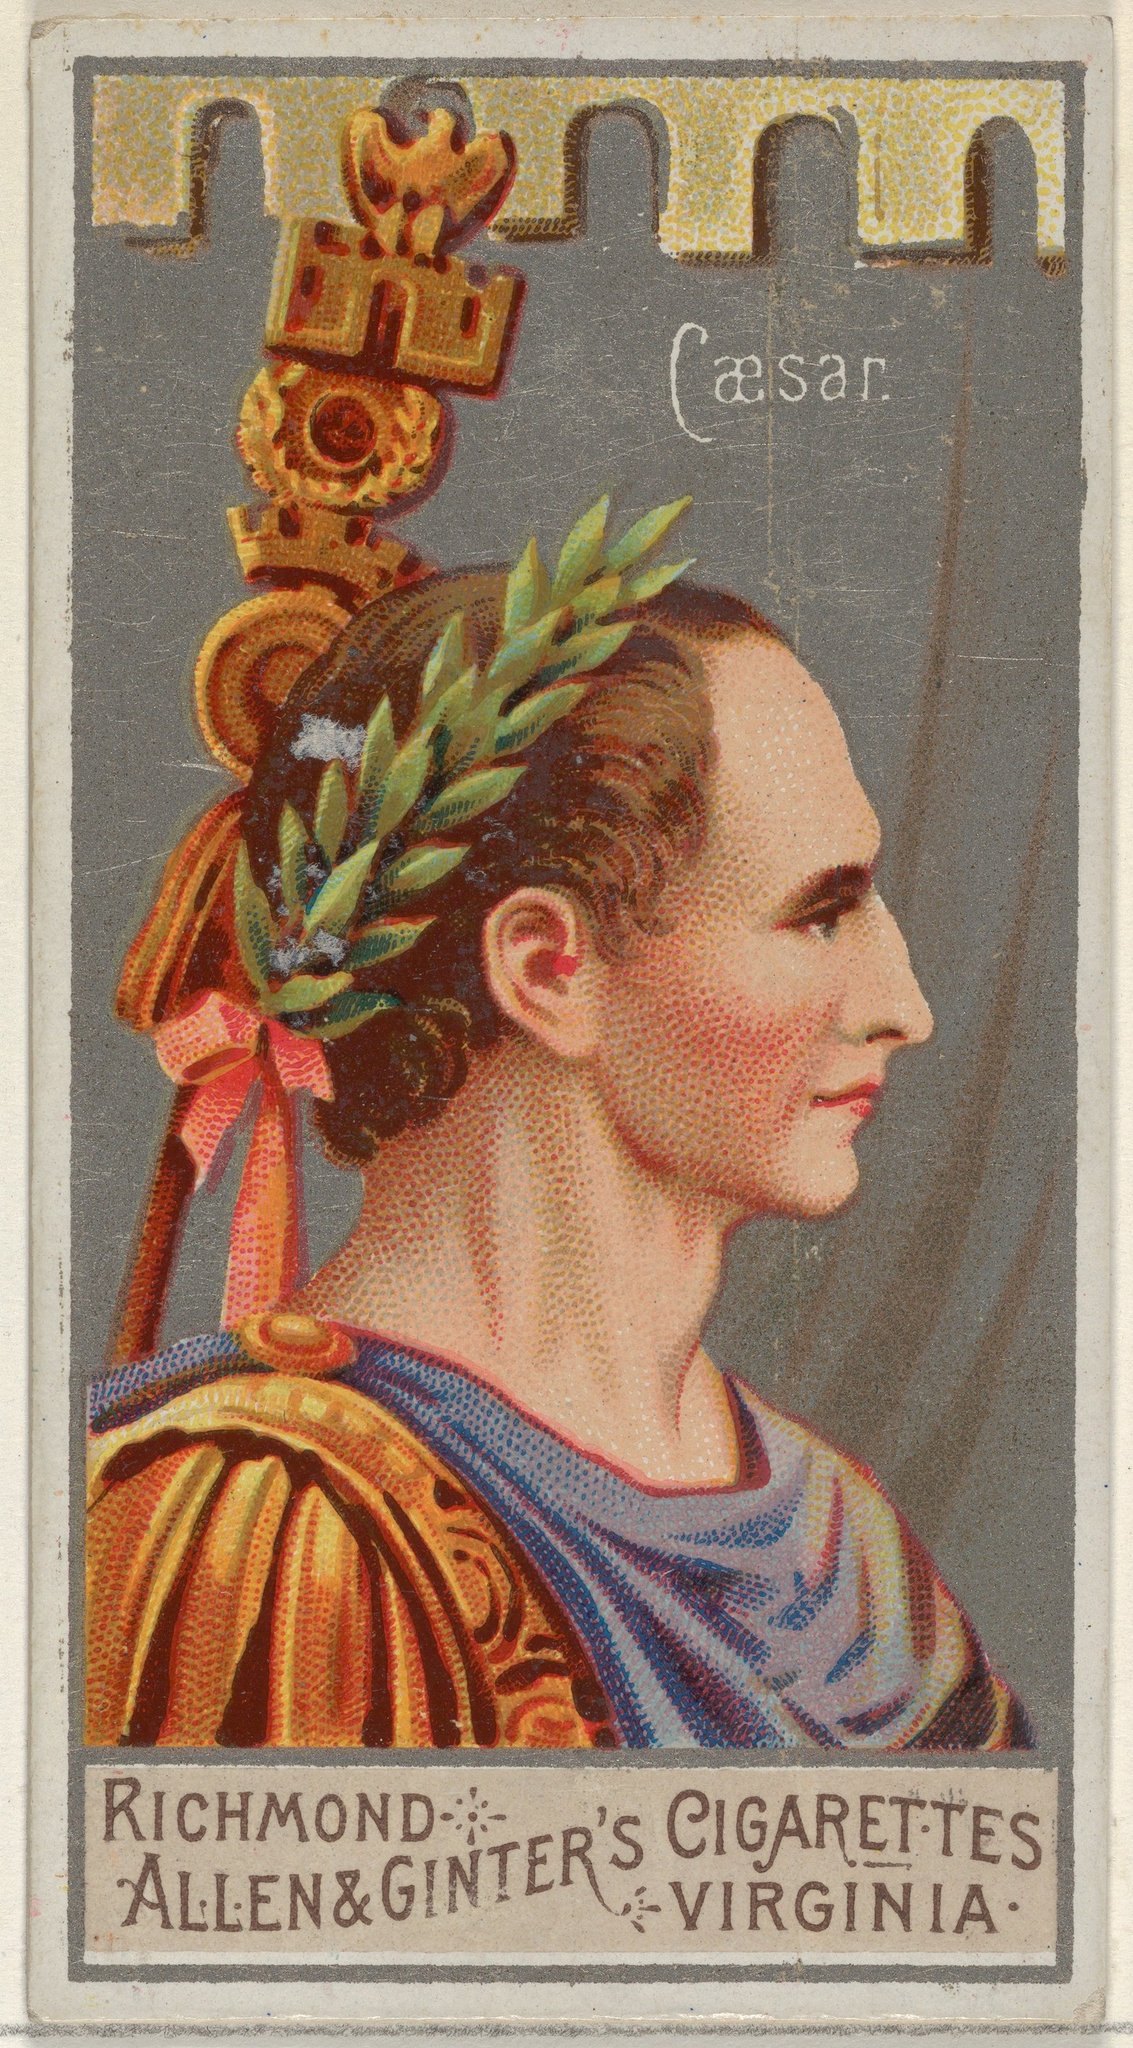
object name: print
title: Gaius Julius Cæsar, from the Great Generals series (N15) for Allen & Ginter Cigarettes Brands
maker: allen & ginter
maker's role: publisher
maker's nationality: american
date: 1888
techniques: color lithograph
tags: julius caesar,profiles